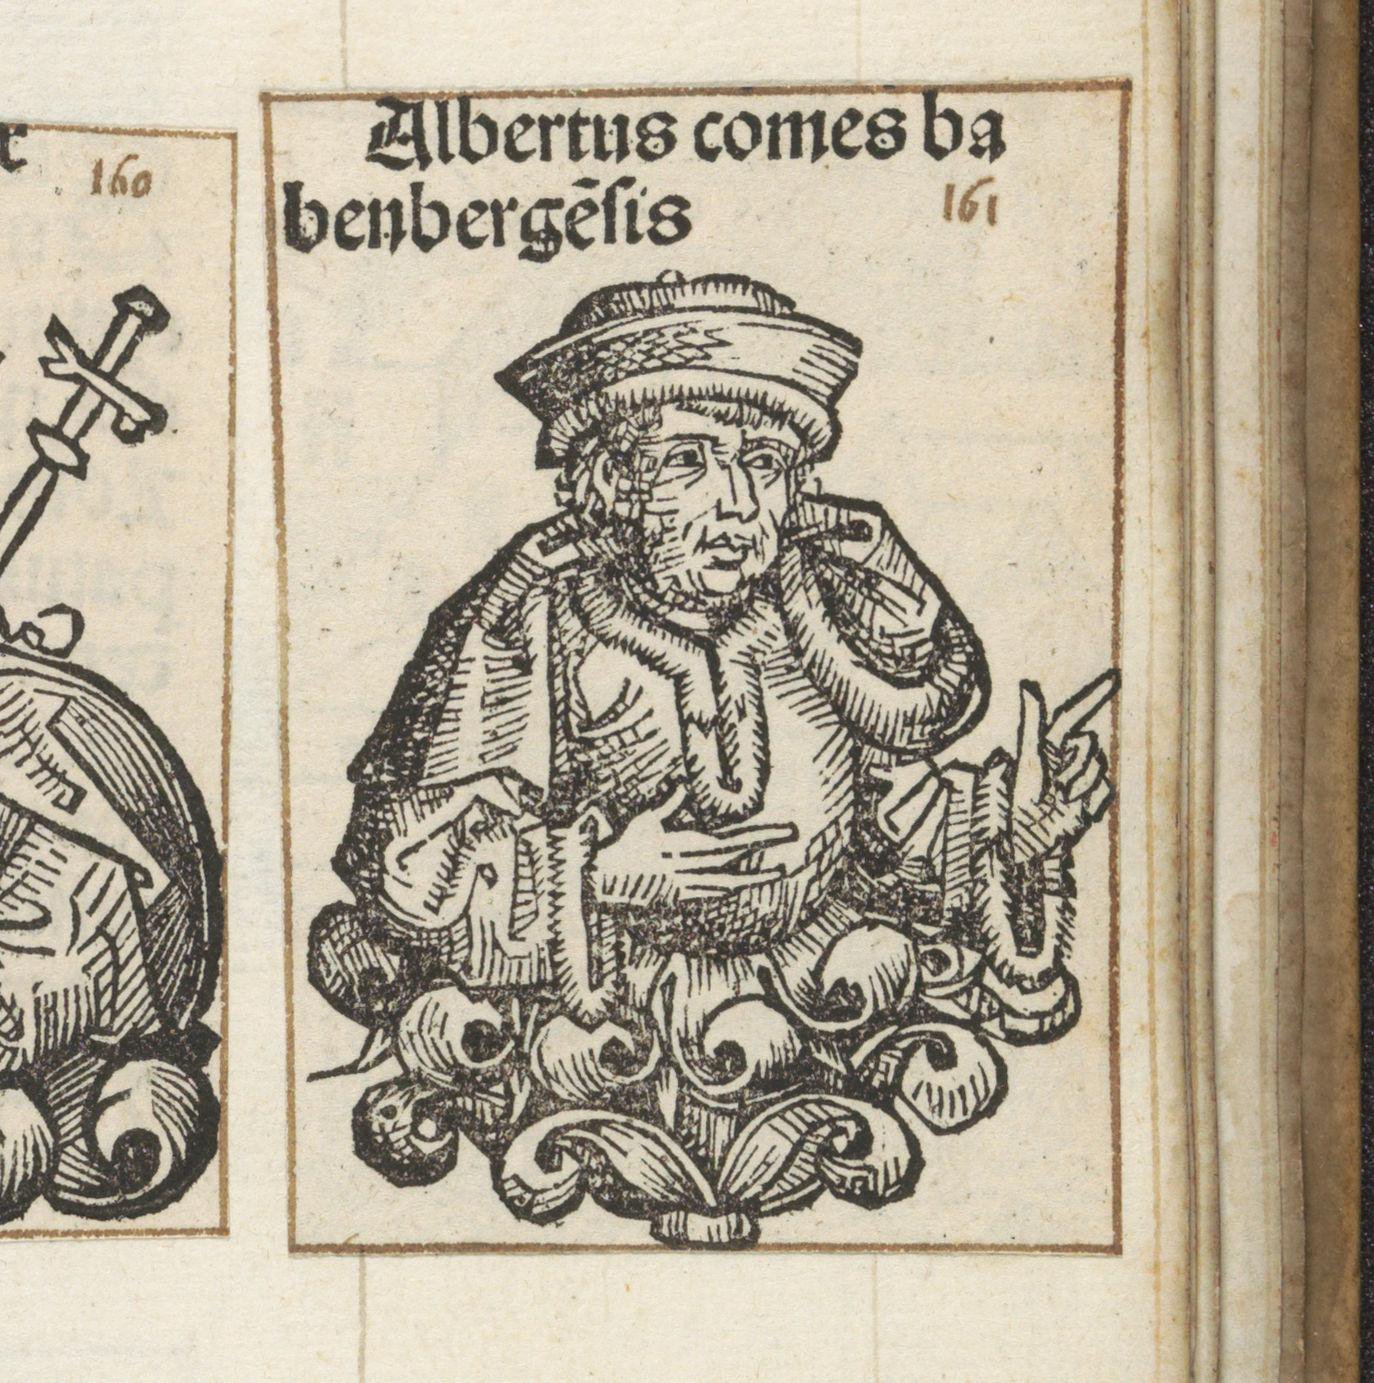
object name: book illustration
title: Rudolphus rex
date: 1493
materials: paper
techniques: letterpress printing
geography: nuremberg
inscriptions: inscription: ‘161’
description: De houtsnede wordt herhaaldelijk gebruikt als boekillustratie in de Liber Chronicarum (of Neurenbergkroniek) van Hartmann Schedel, verschenen in het Latijn en Duits in 1493. Zie de Latijnse uitgave, folio 174r.